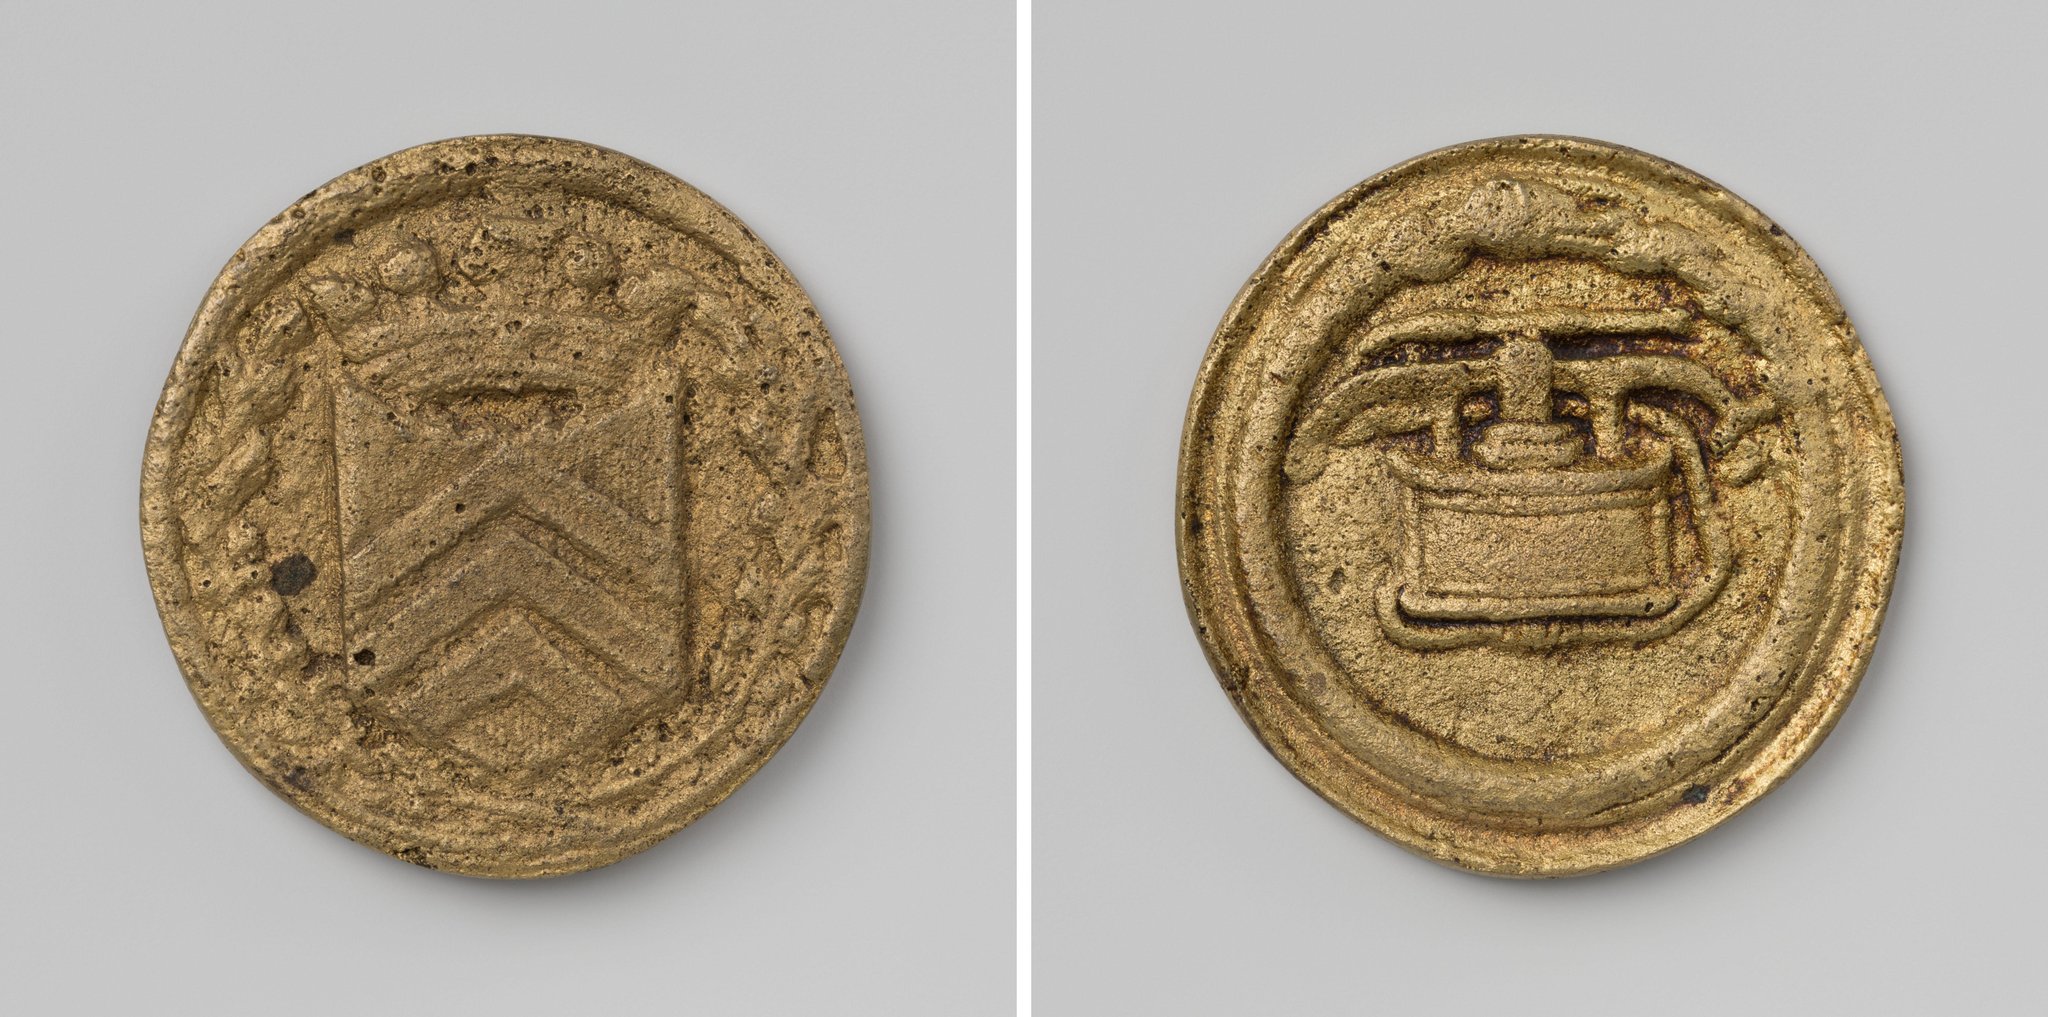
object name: fire engine medal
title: Den Helder, brandspuitpenning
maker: Anonymous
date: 1680-1800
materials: brass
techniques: casting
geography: den helder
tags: den helder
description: Messing penning. Voorzijde: gekroond wapenschild binnen bladerkrans. Keerzijde: brandspuit binnen slangerond